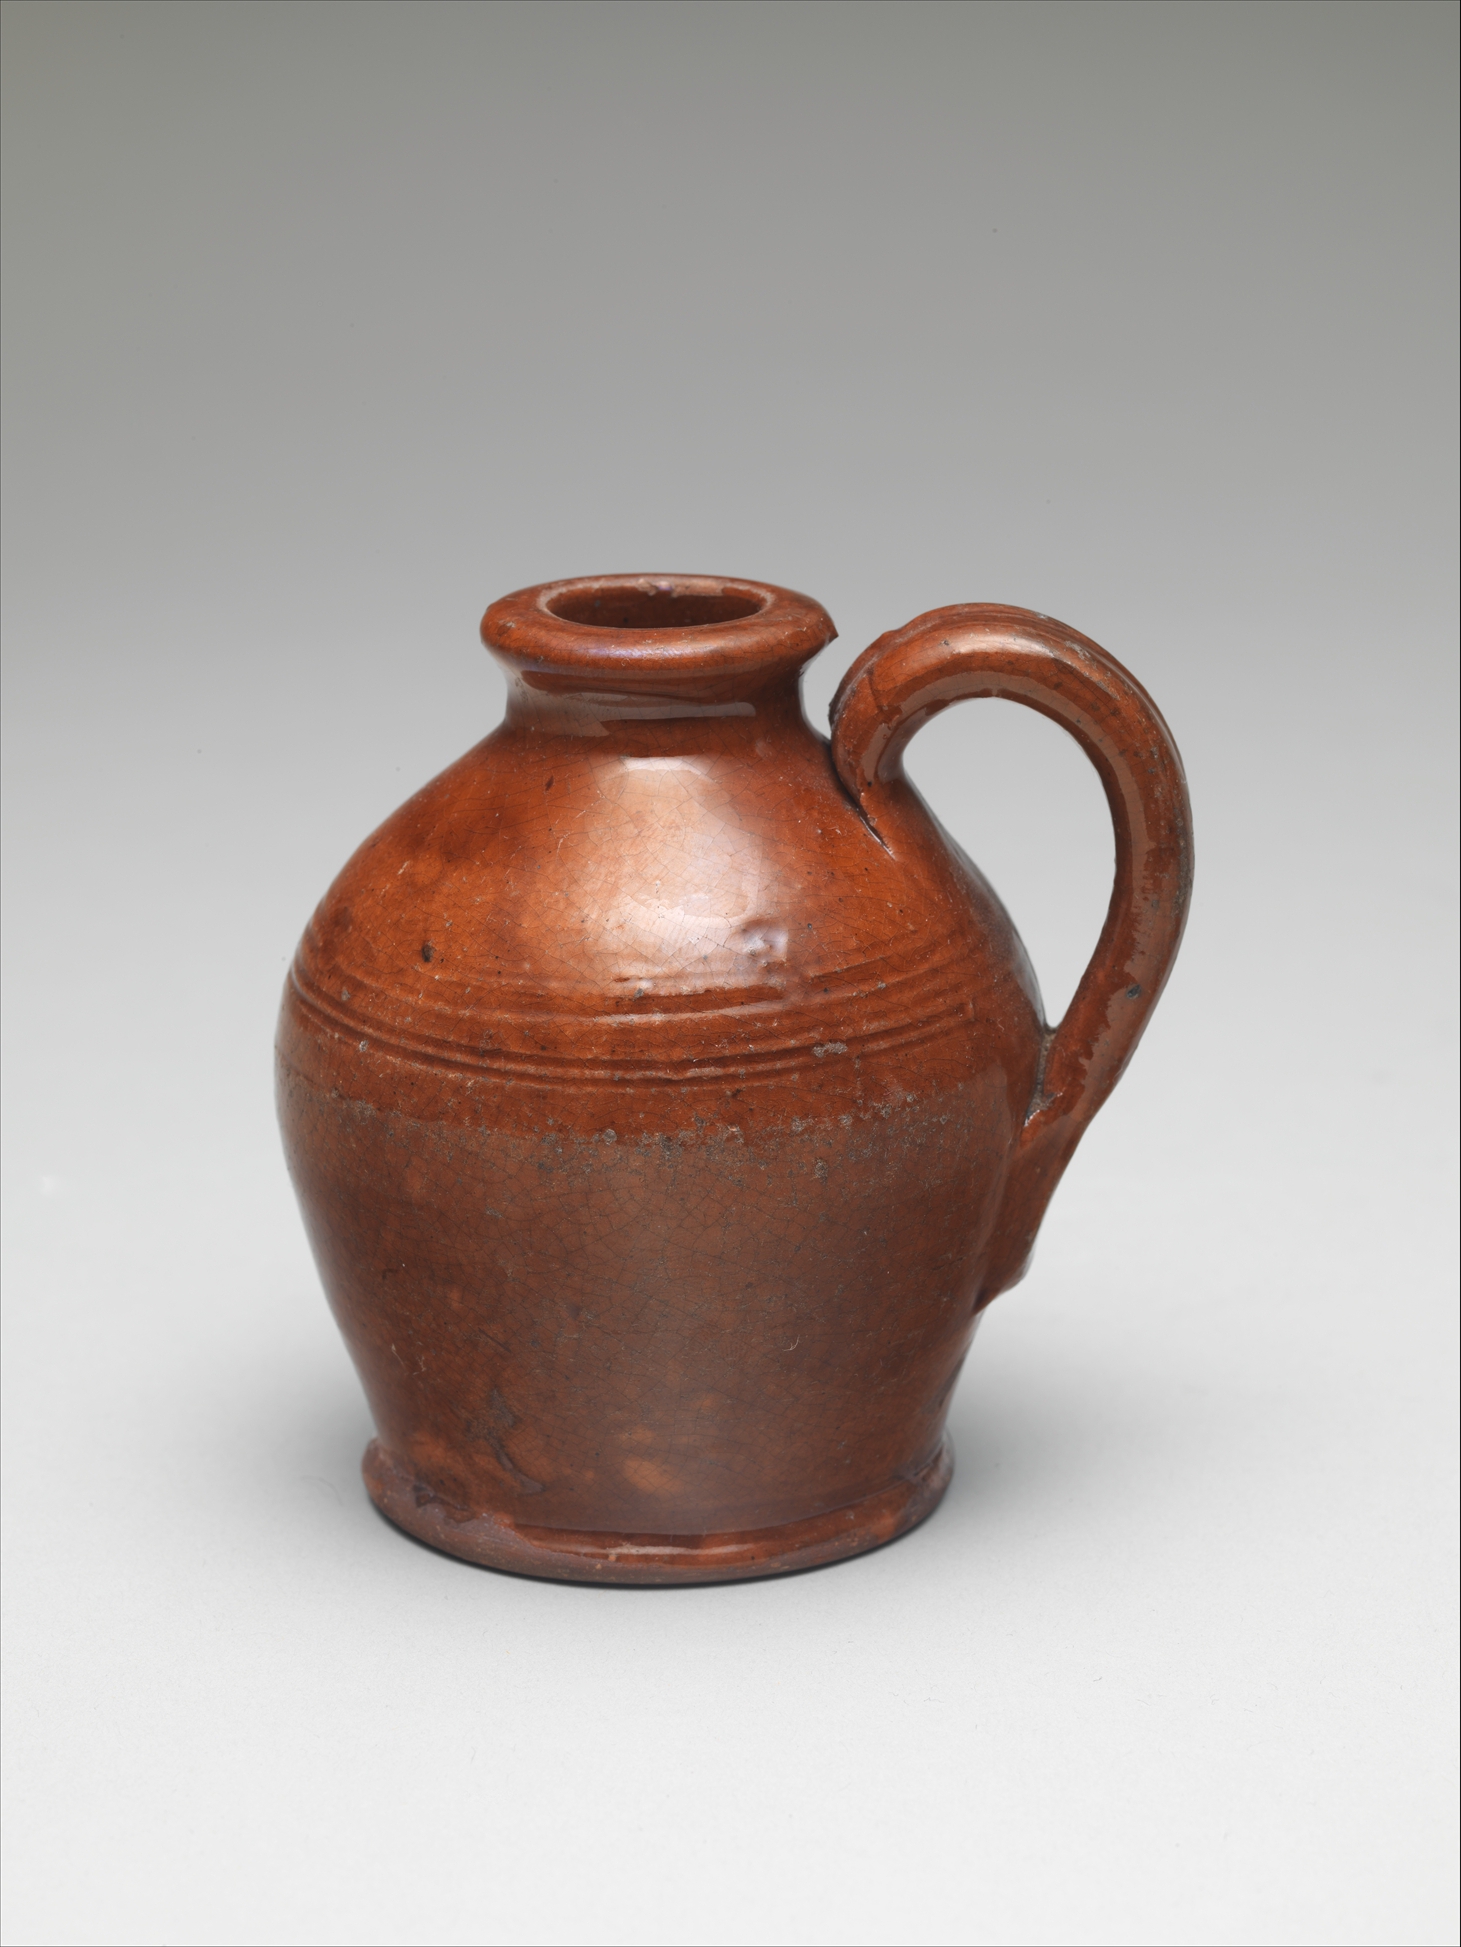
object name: cruet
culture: american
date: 1800-1900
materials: earthenware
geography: united states